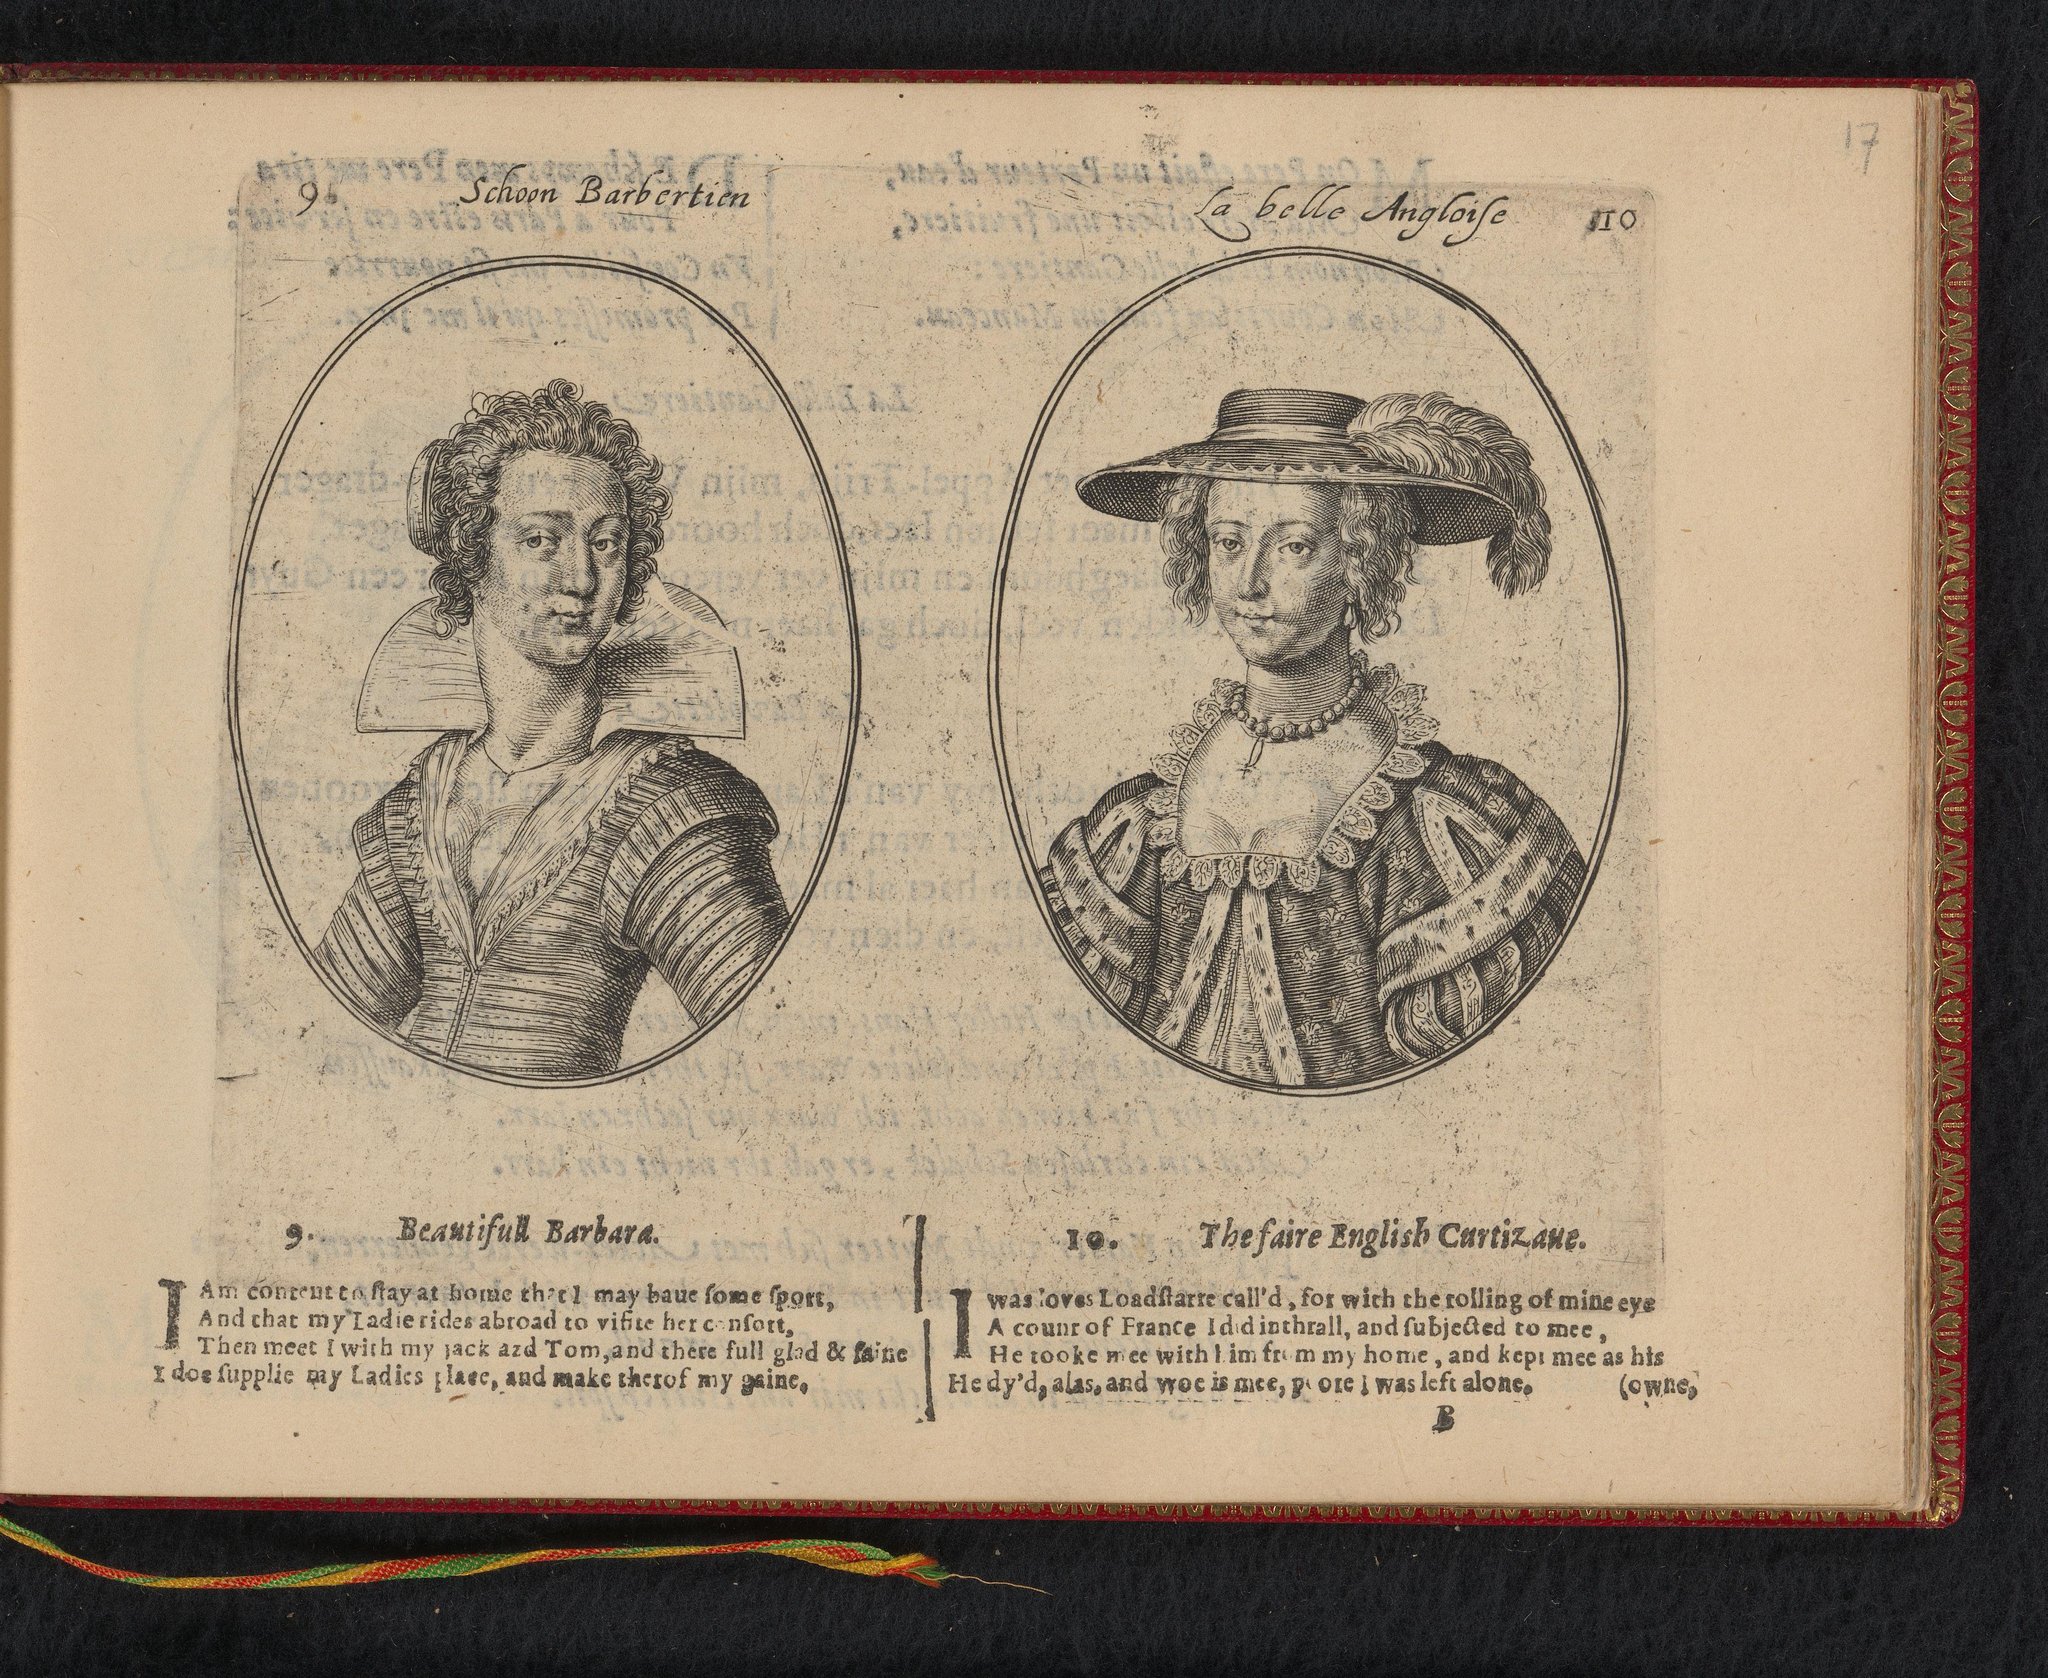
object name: print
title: Portretten van de courtisanes genaamd de Schone Barbara en La belle Anglaise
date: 1635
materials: paper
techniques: engraving, letterpress printing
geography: utrecht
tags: herding, herdsman, herdswoman, shepherd, shepherdess, cowherd, etc.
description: Twee voorstellingen op een albumblad. Links de courtisane de Schone Barbertien (of Barbara) en rechts La belle Anglaise. Daaronder twee kwatrijnen in het Engels. Het blad maakt deel uit van een album.